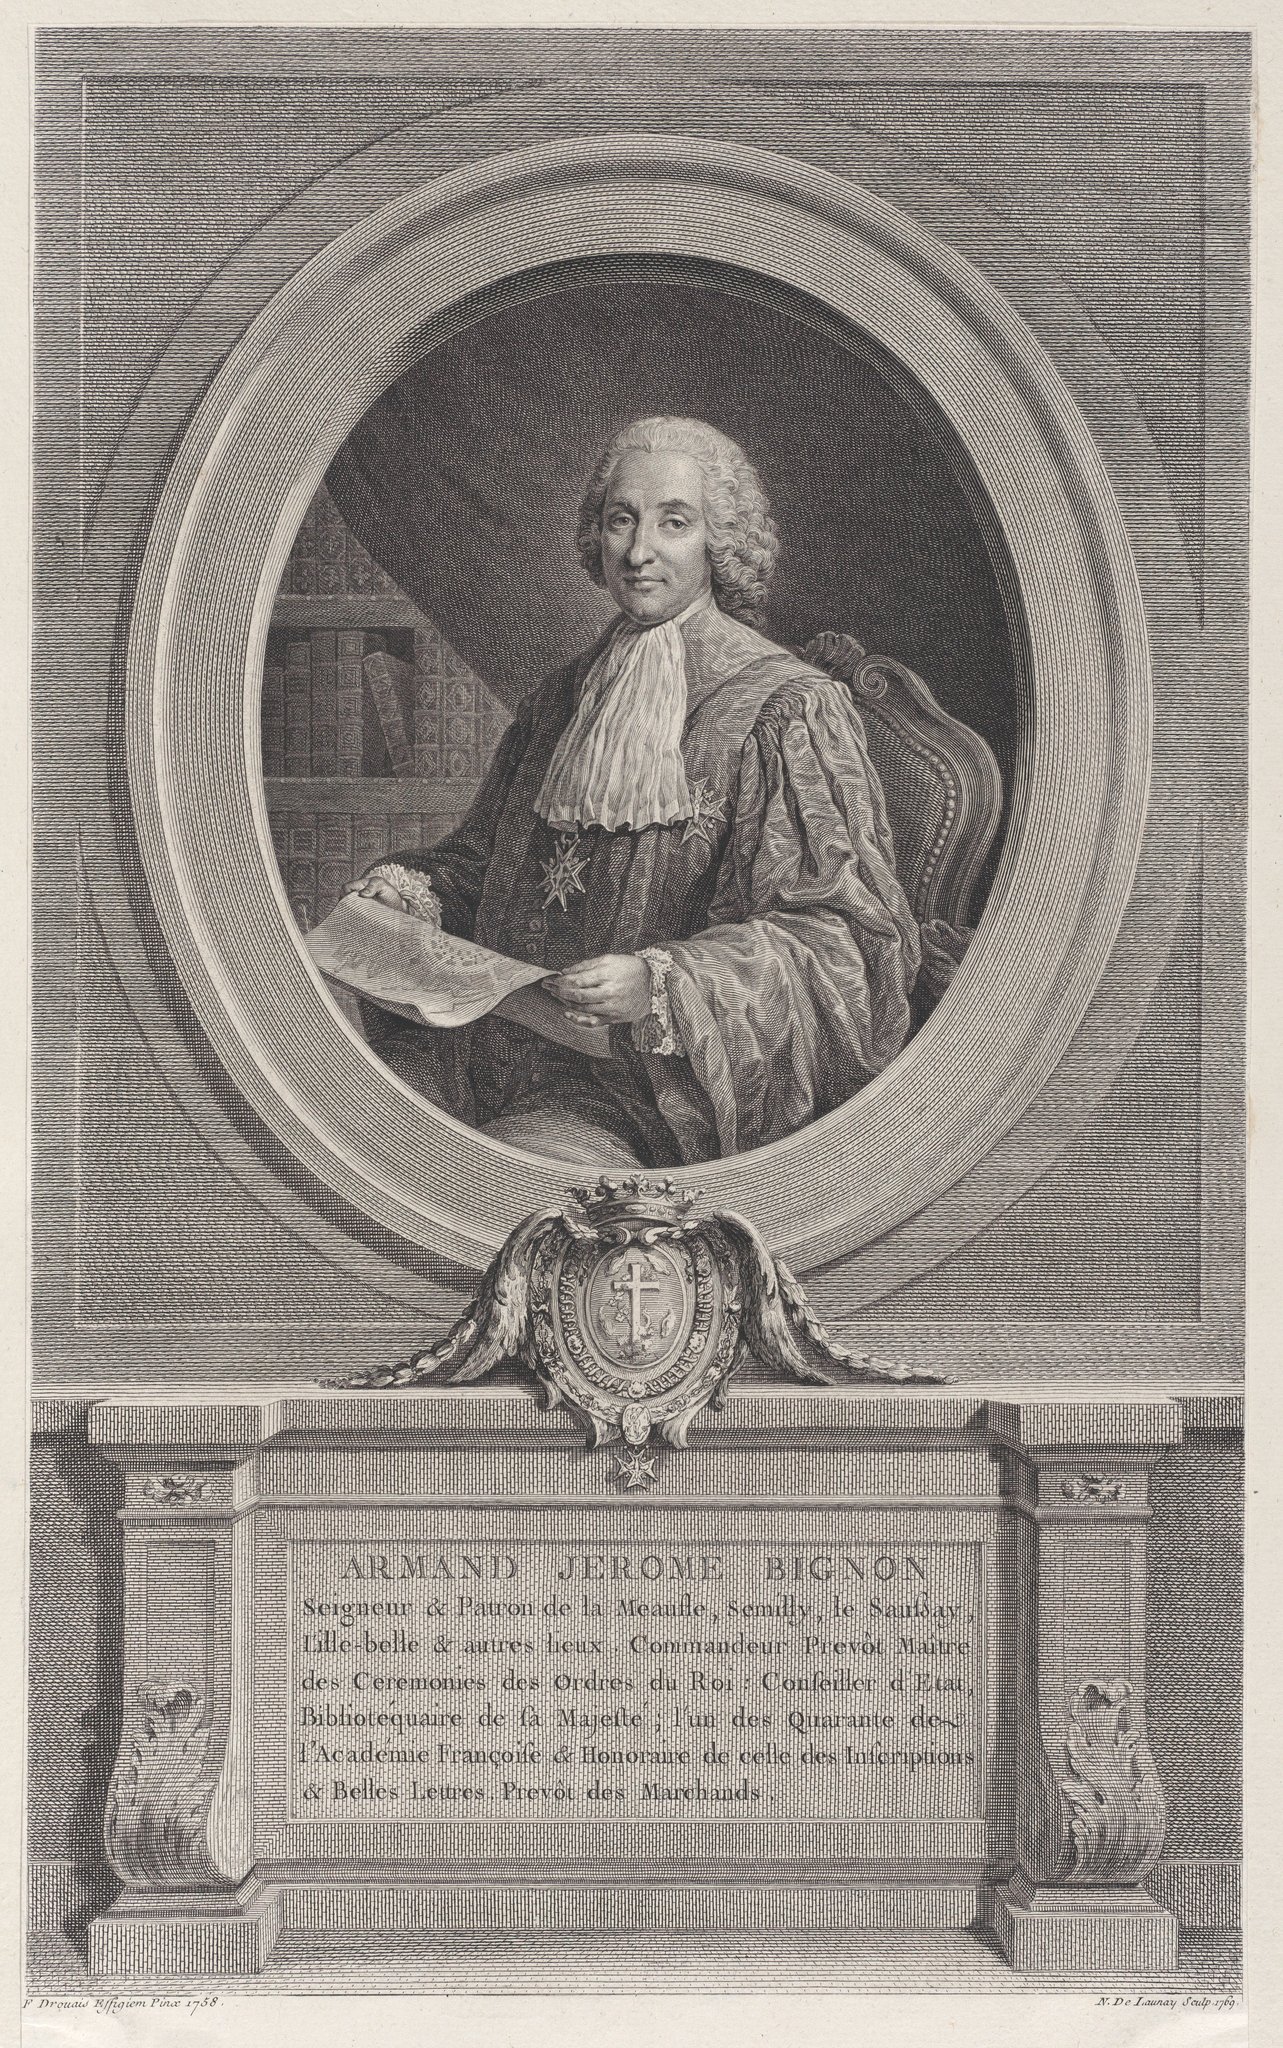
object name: print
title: Portrait of Armand-Jérôme Bignon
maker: nicolas de launay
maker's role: artist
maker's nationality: french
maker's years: 1739-1792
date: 1769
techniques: engraving